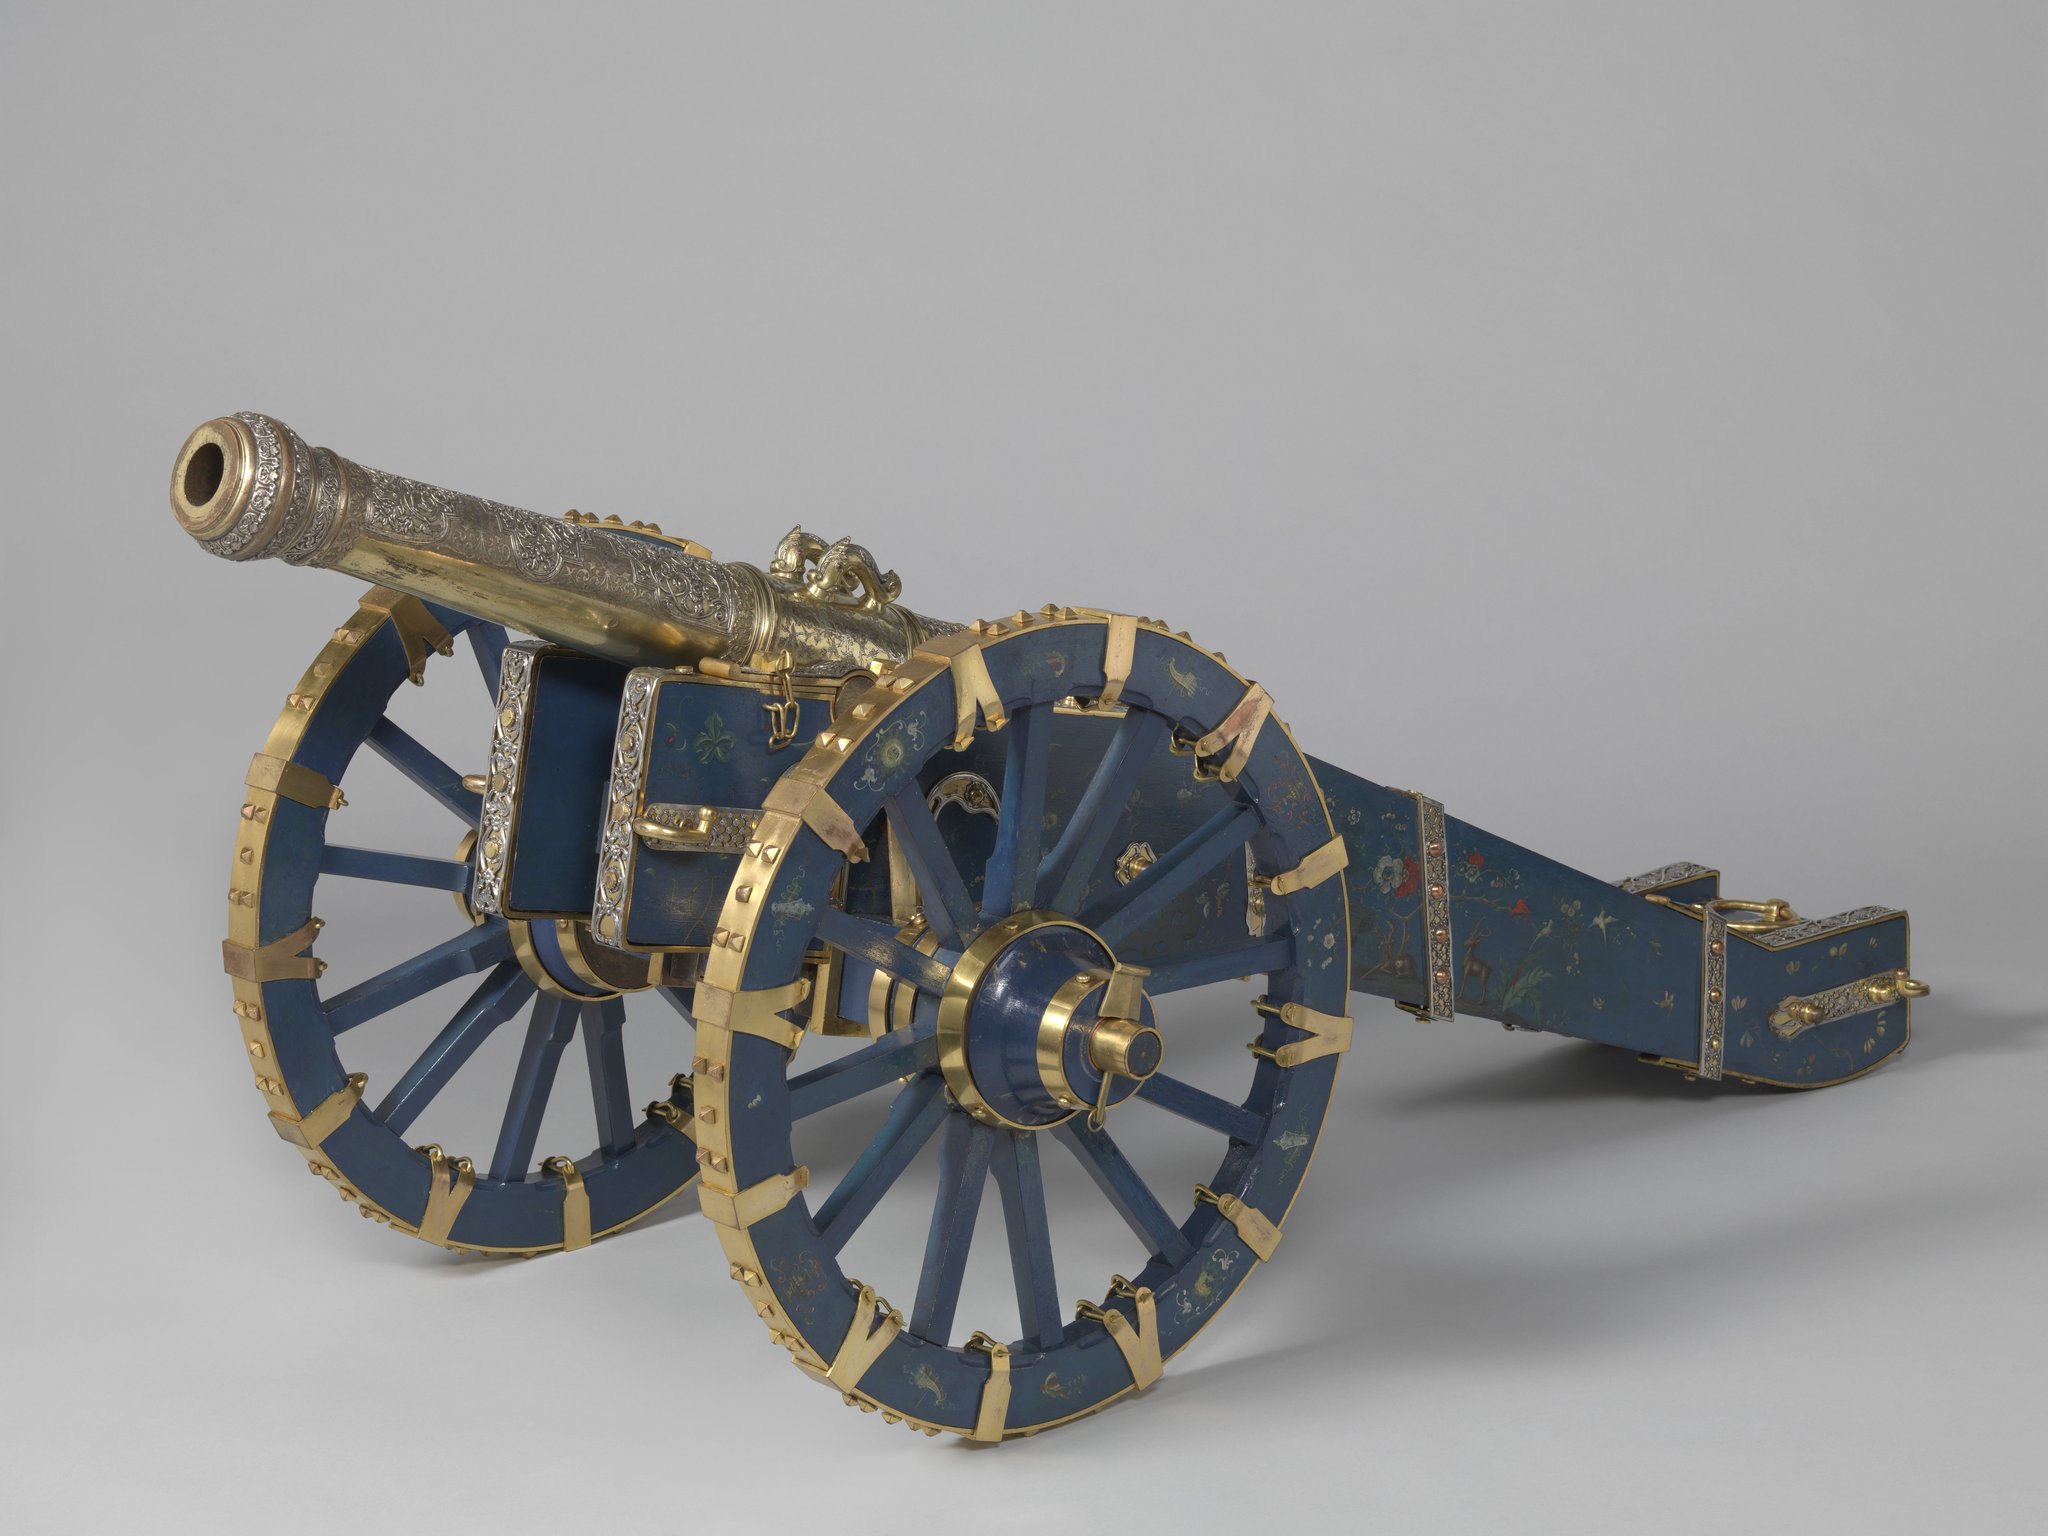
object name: gun mount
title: Singalees kanon of Lewuke's kanon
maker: Anonymous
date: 1745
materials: bronze, gold, gemstone, silver, wood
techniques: casting, inlay, painted, sawing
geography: sri lanka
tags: the hague, william v (prince of orange), netherlands, sri lanka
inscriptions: inscription: ‘Saka-war a ekwadahäsa -sa _ siya häta-hatata pämini Krodha-namwu mema war a _ yehi Iswaradhipatiwu a - ntima-winstiyehidi sata _ ra Korale Disawa läbi ti - bena Lewuke-tenannä _ hawisin wädakrawa da - kkawapu kalatuwa _ kkuwayi’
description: This cannon was part of a group of six Sinhalese weapons from the Rijksmuseum’s collection that the Dutch State returned to Sri Lanka in 2023. After conducting joint provenance research, it was concluded that these weapons had been captured by Dutch troops during the siege of the city of Kandy in Sri Lanka in 1765. Hence, there was involuntary loss of possession, prompting the restitution of these objects. The cannon and the other weapons are now on display at the Colombo National Museum.